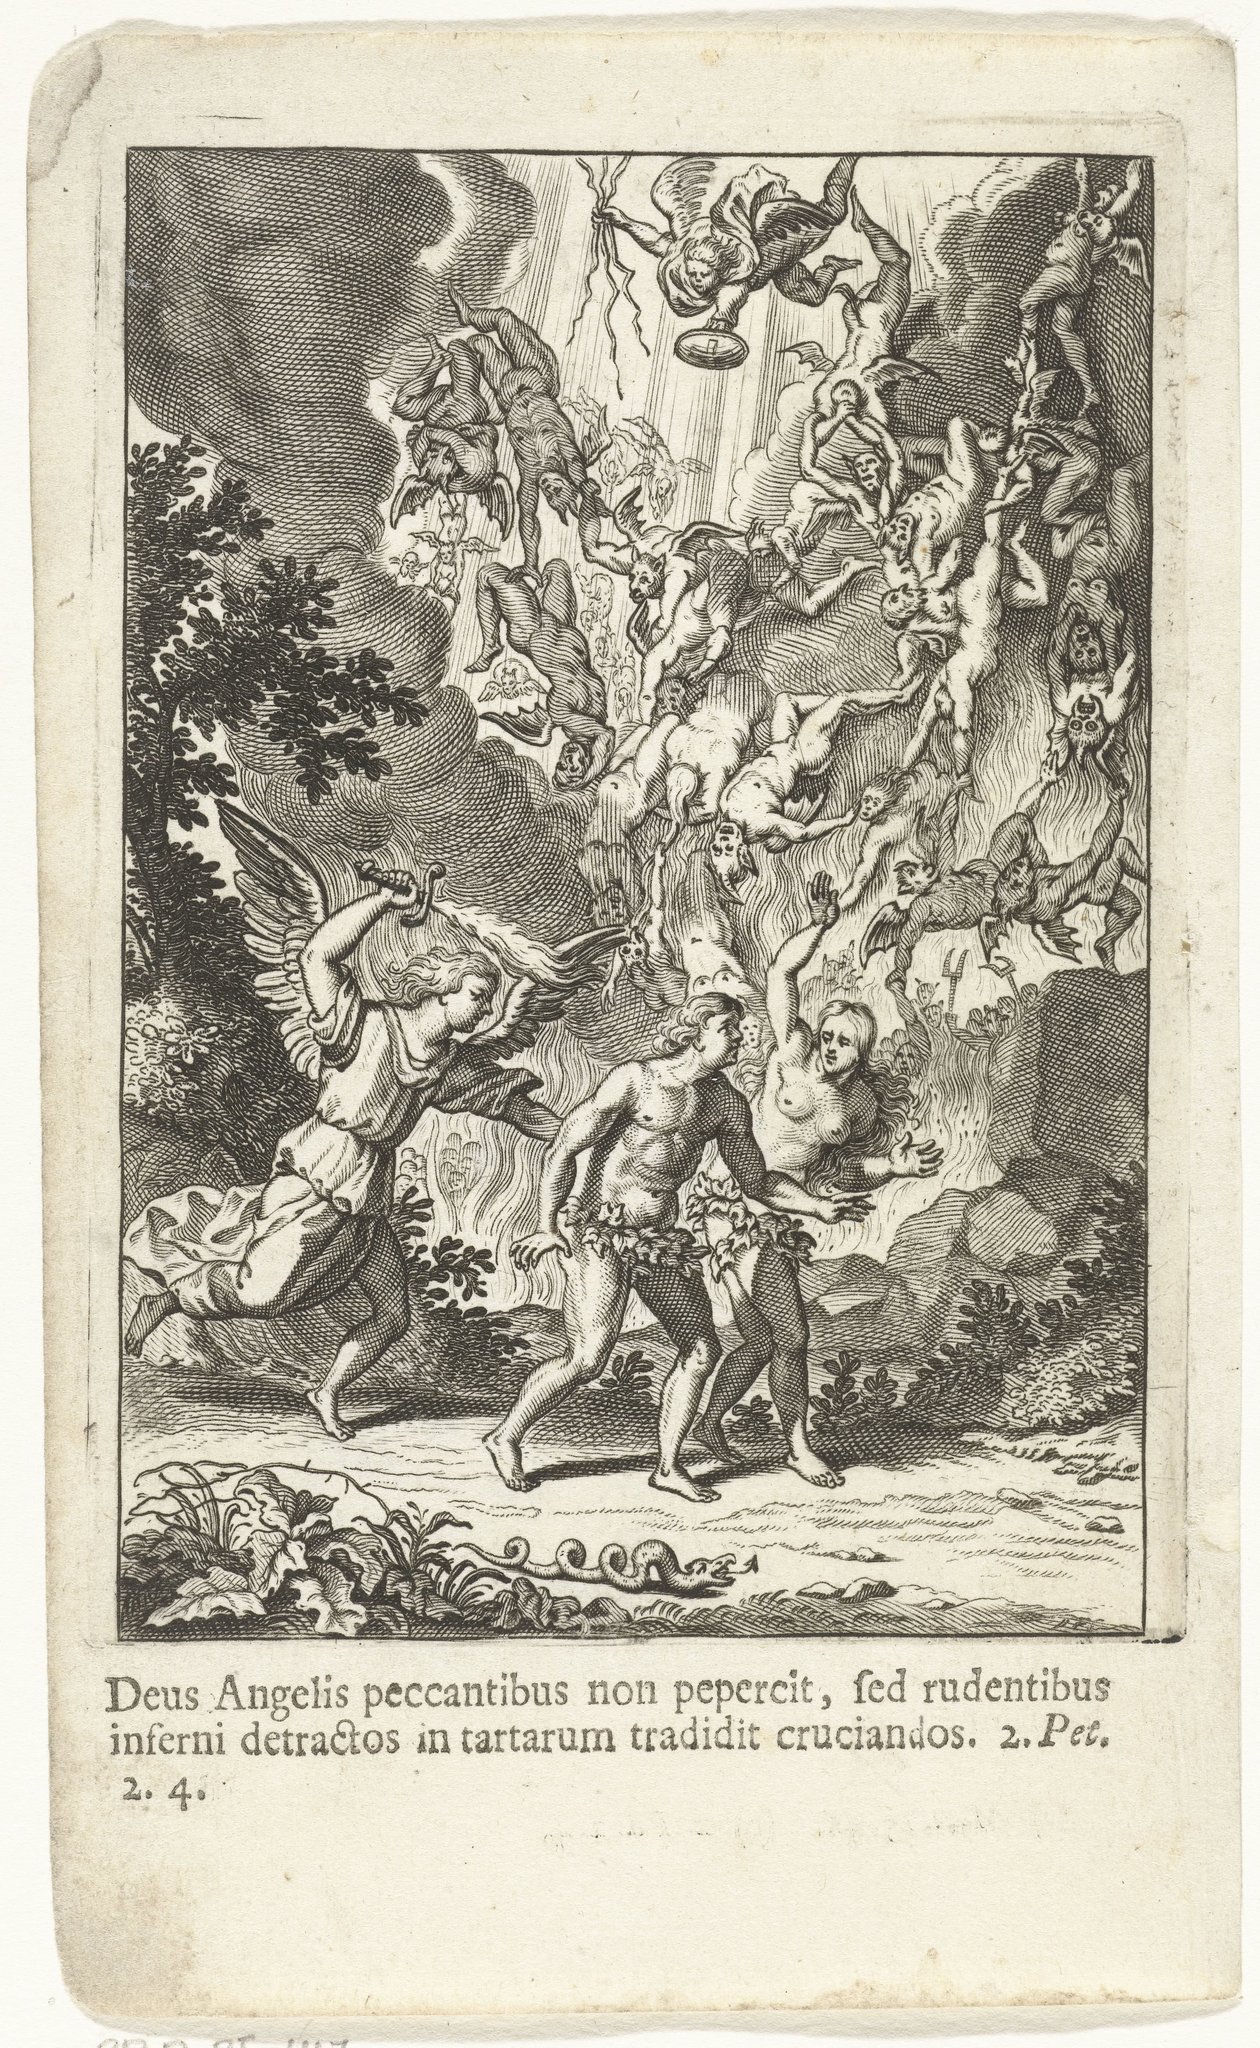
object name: print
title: Expulsion from Paradise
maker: jan baptist berterham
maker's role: print maker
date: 1696-1721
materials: paper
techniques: etching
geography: brussels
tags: expulsion of adam and eve from paradise (genesis 3:22-24)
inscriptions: collector's mark: Lugt 2228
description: Verdrijving van Adam en Eva uit het paradijs. Onder de voorstelling staat de bijbehorende bijbeltekst.